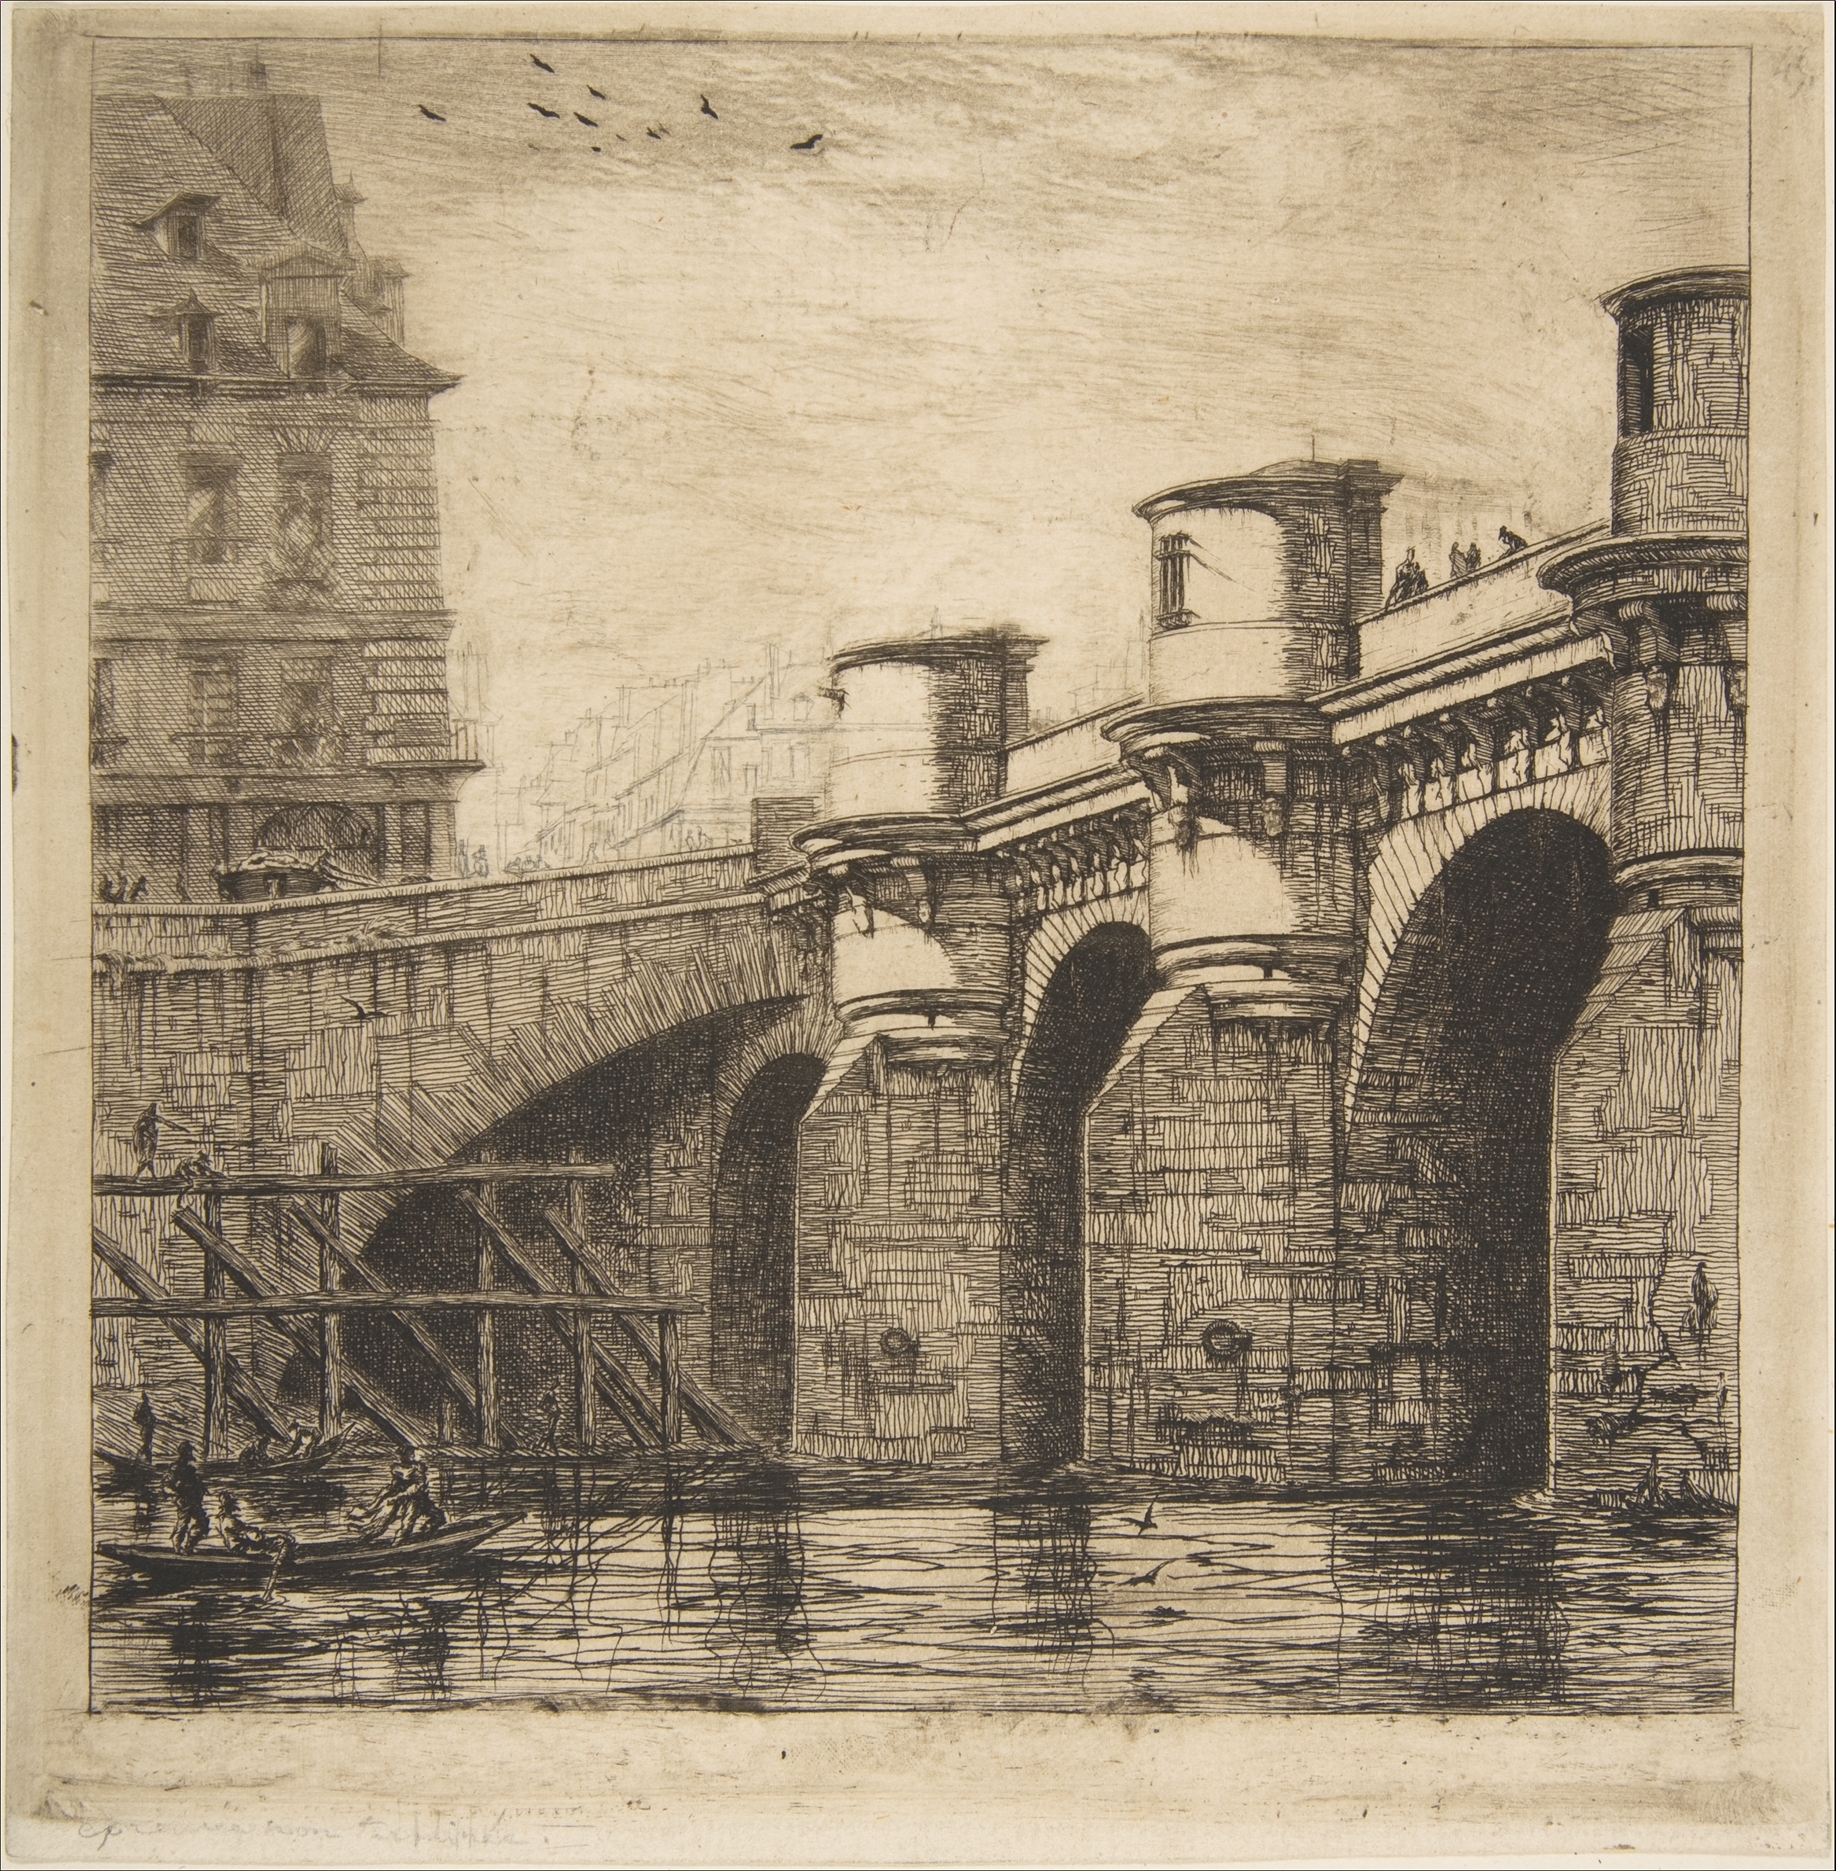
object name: print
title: Pont-Neuf, Paris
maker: charles meryon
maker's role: artist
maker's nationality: french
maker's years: 1821-1868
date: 1853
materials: graphite, paper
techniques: burnishing, drypoint, etching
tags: buildings,bridges,rivers,boats,paris